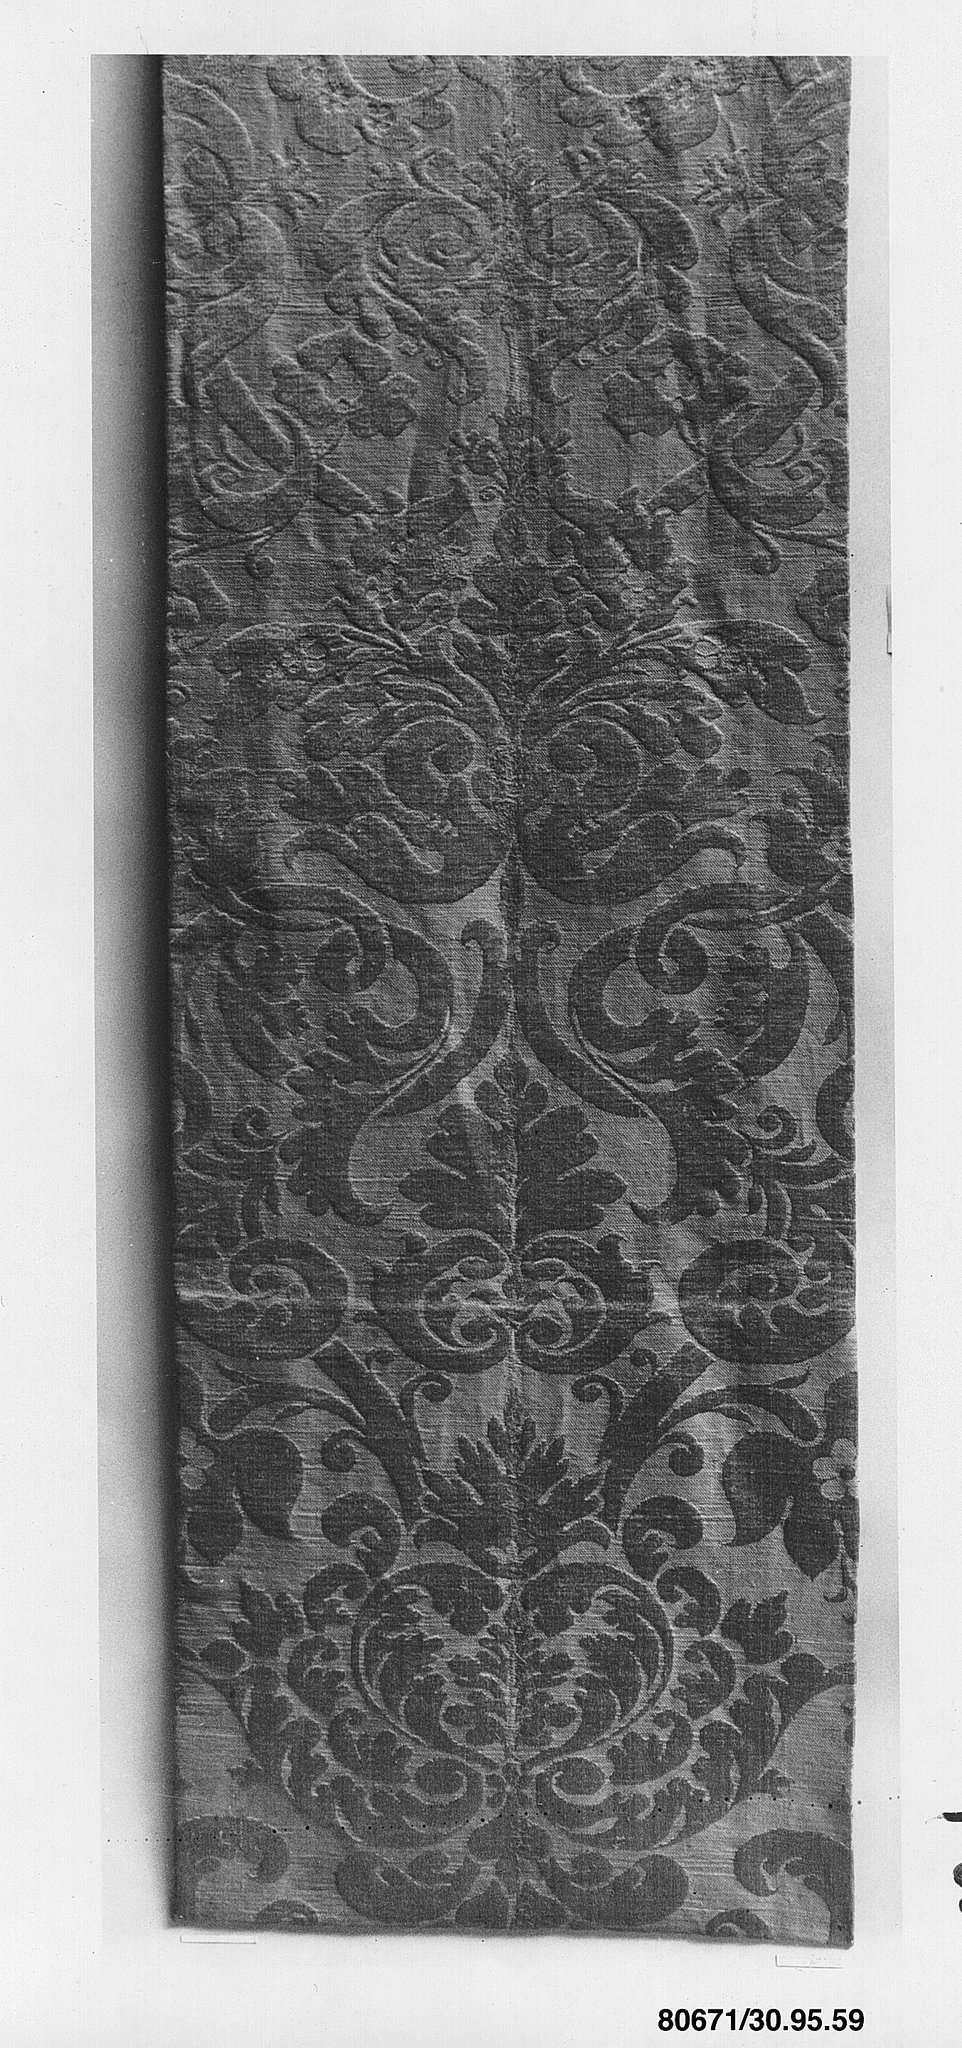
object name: strip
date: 1601-1700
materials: linen, silk